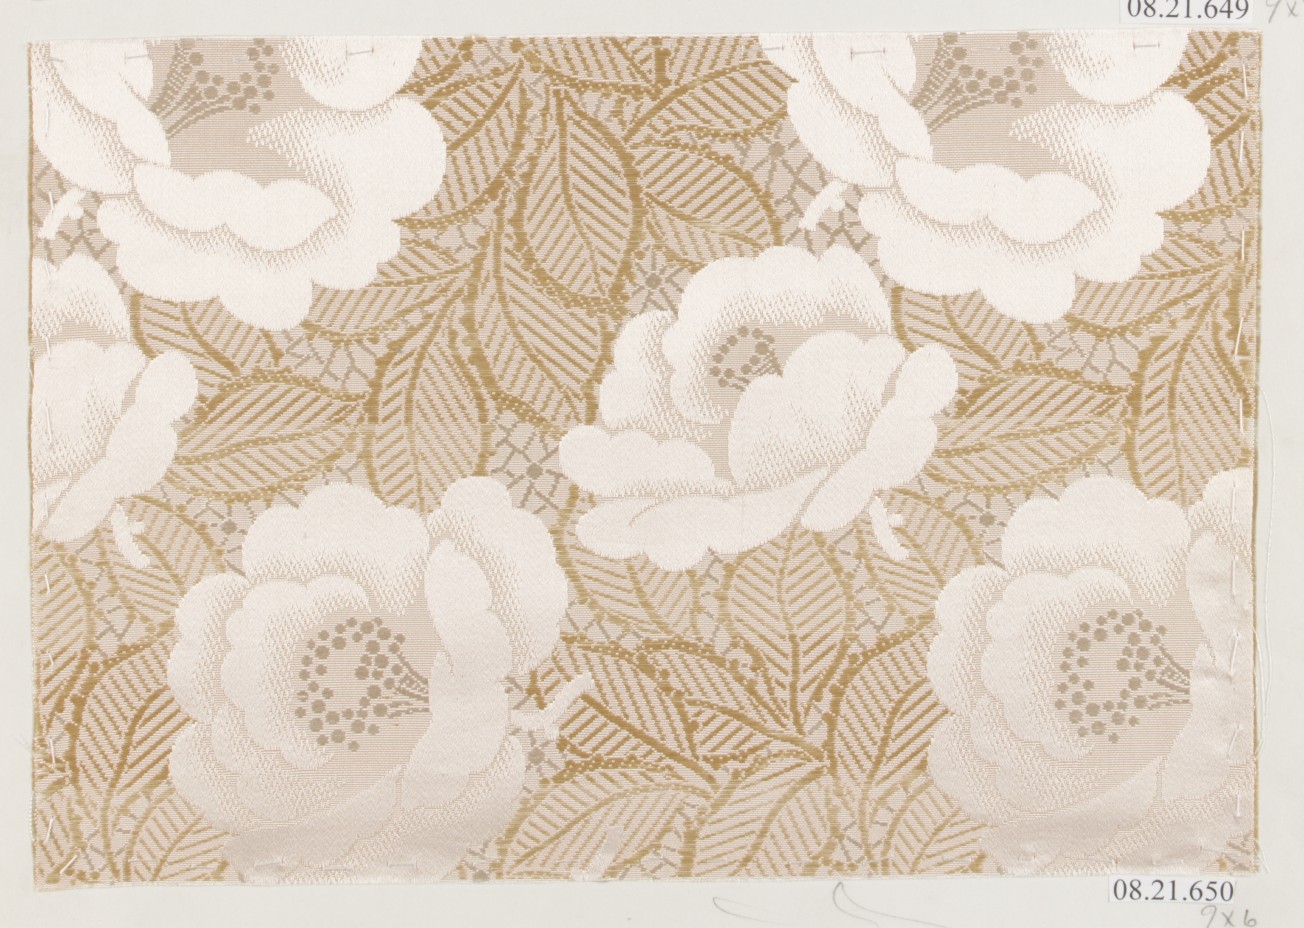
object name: textile sample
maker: Anonymous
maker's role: designer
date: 1900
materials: silk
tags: flowers,leaves